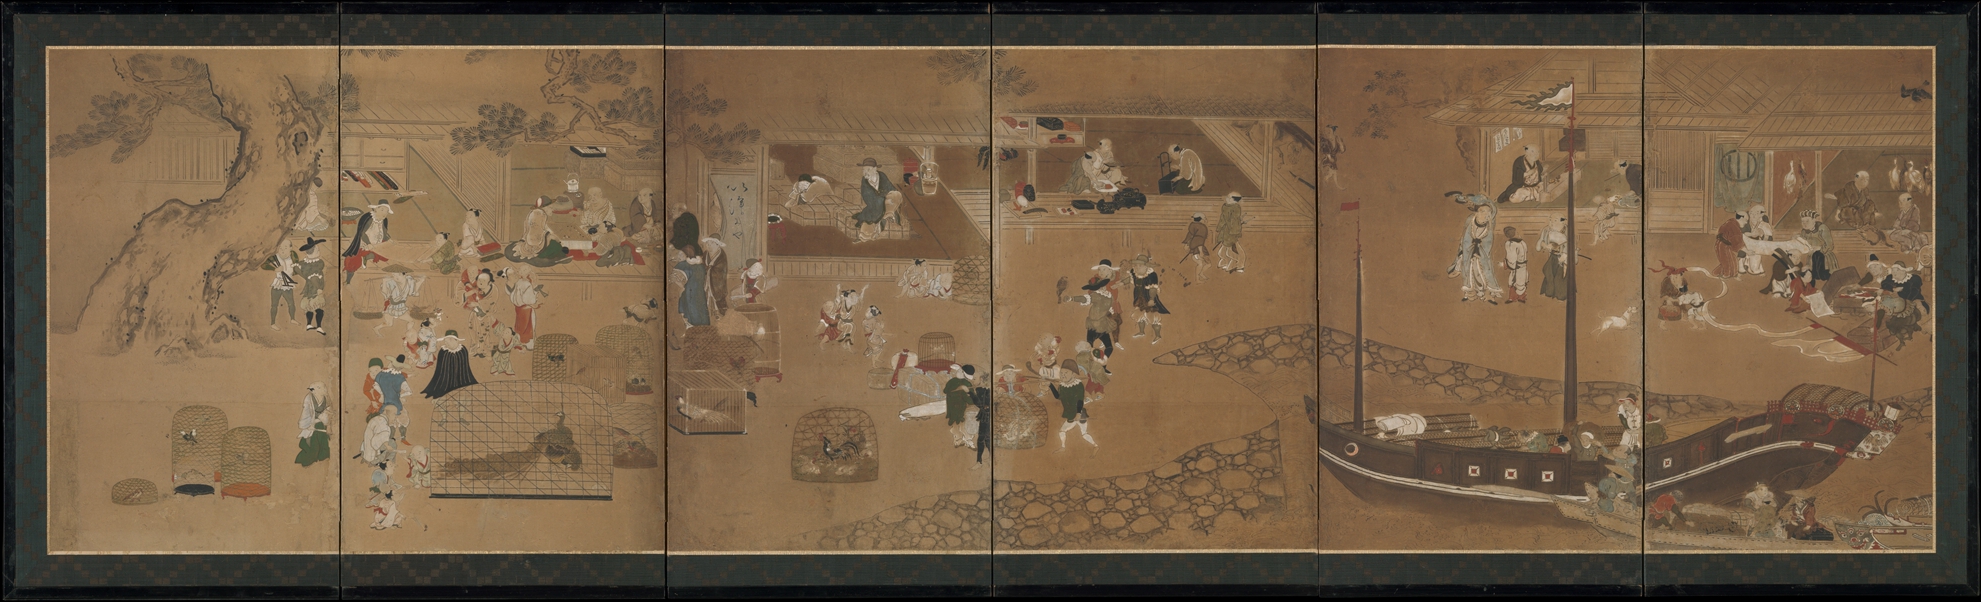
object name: screen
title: Foreign Merchants in Japanese Trade Port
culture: japanese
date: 1801-1833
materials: ink, panel, paper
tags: peacocks,roosters,merchants,boats